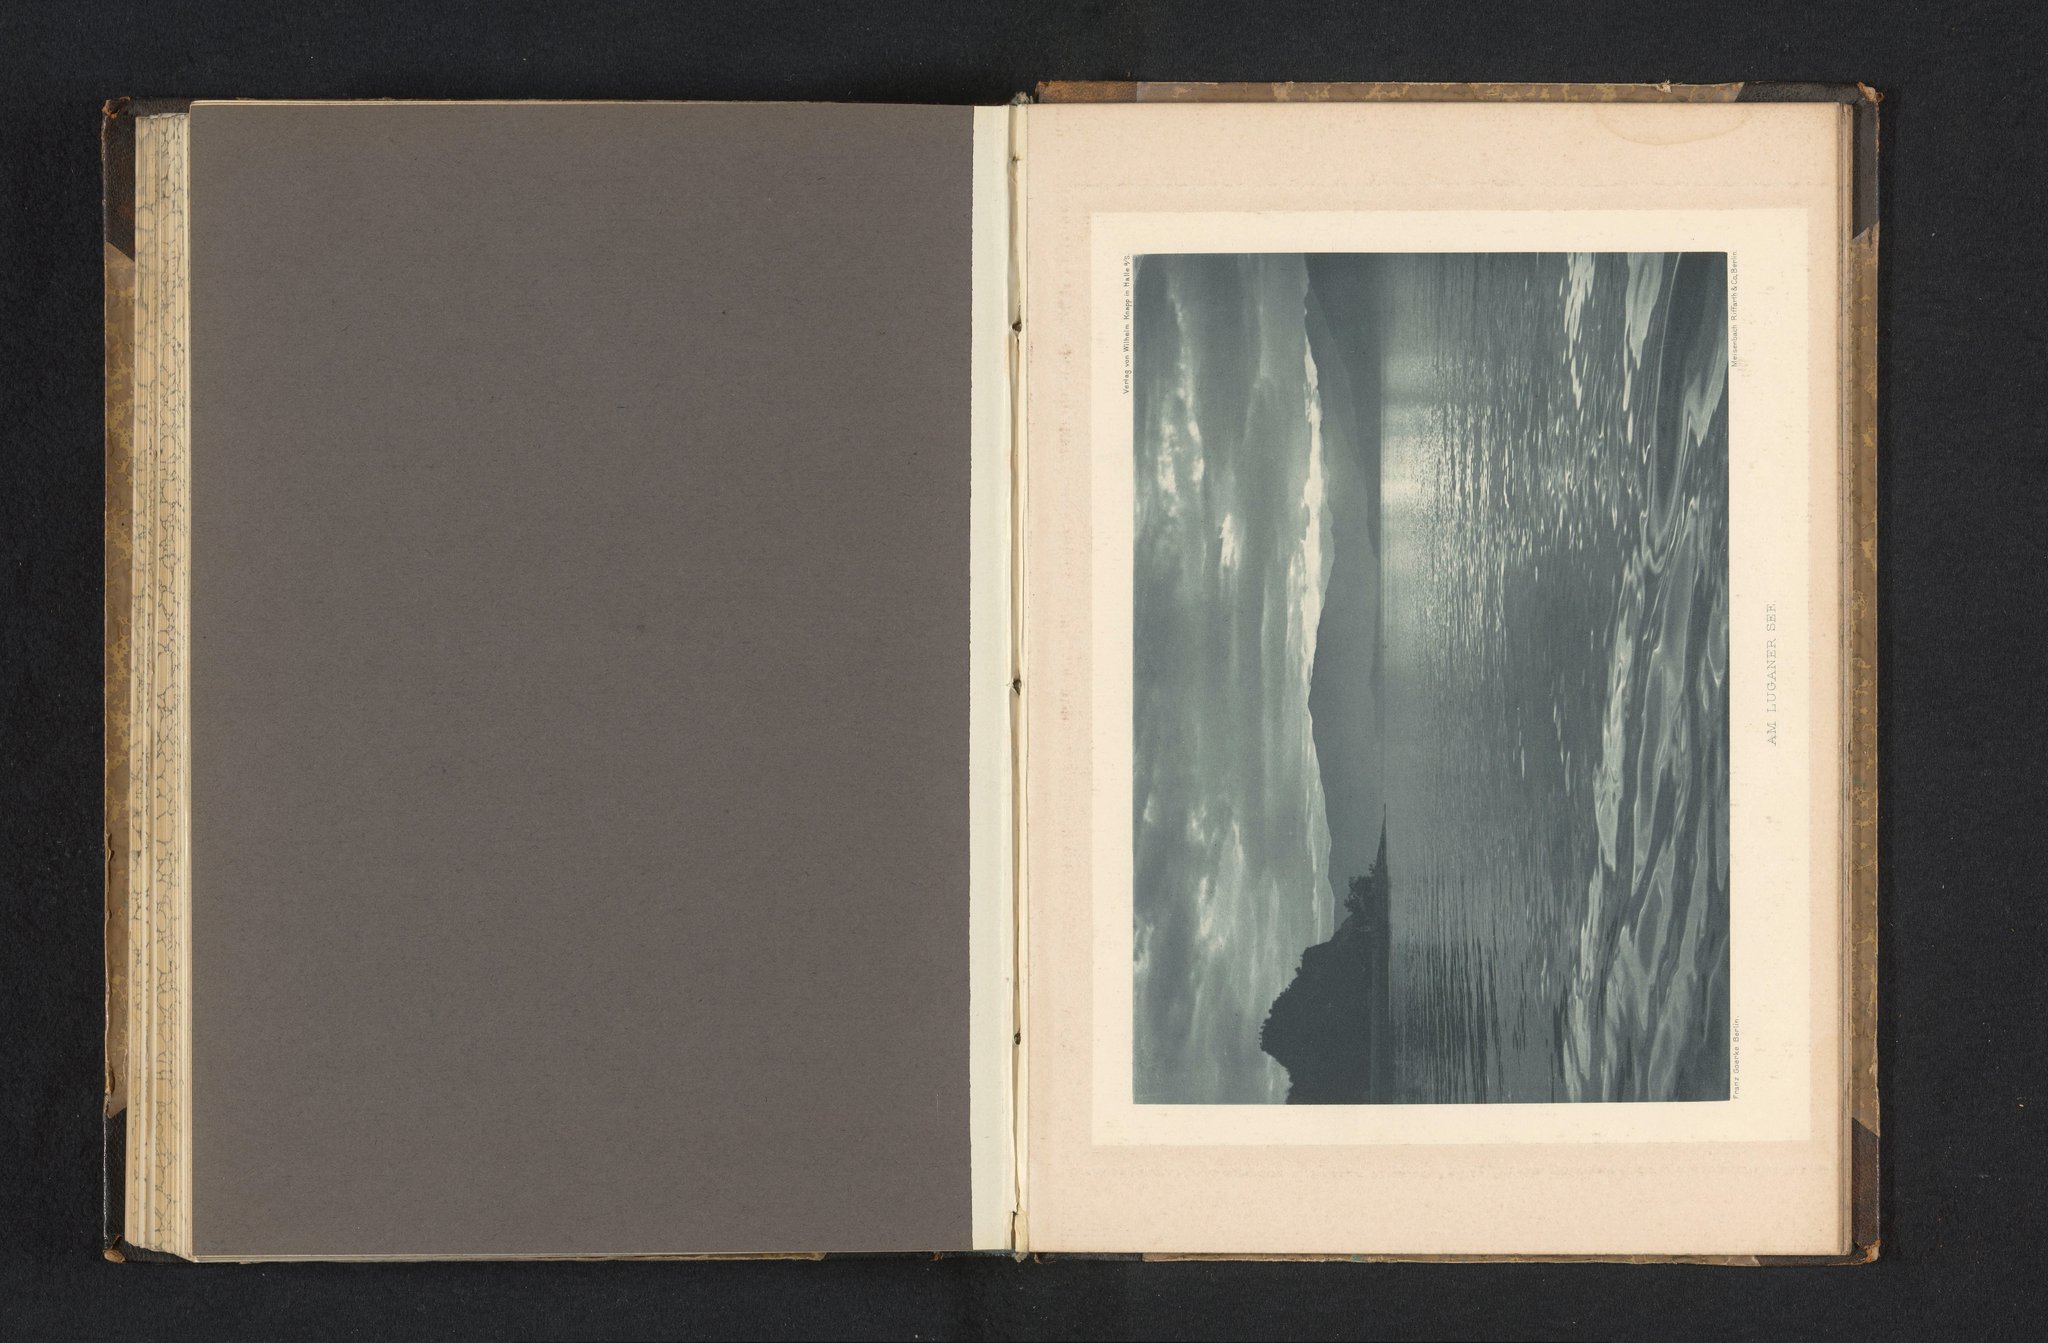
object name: page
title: Am Luganer See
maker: franz goerke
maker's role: fotograaf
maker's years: 1856-1931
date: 1898-1903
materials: paper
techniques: photoaquatint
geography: halle an der saale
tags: lake, mountains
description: Prent vier van veertien prenten achterin het boek.